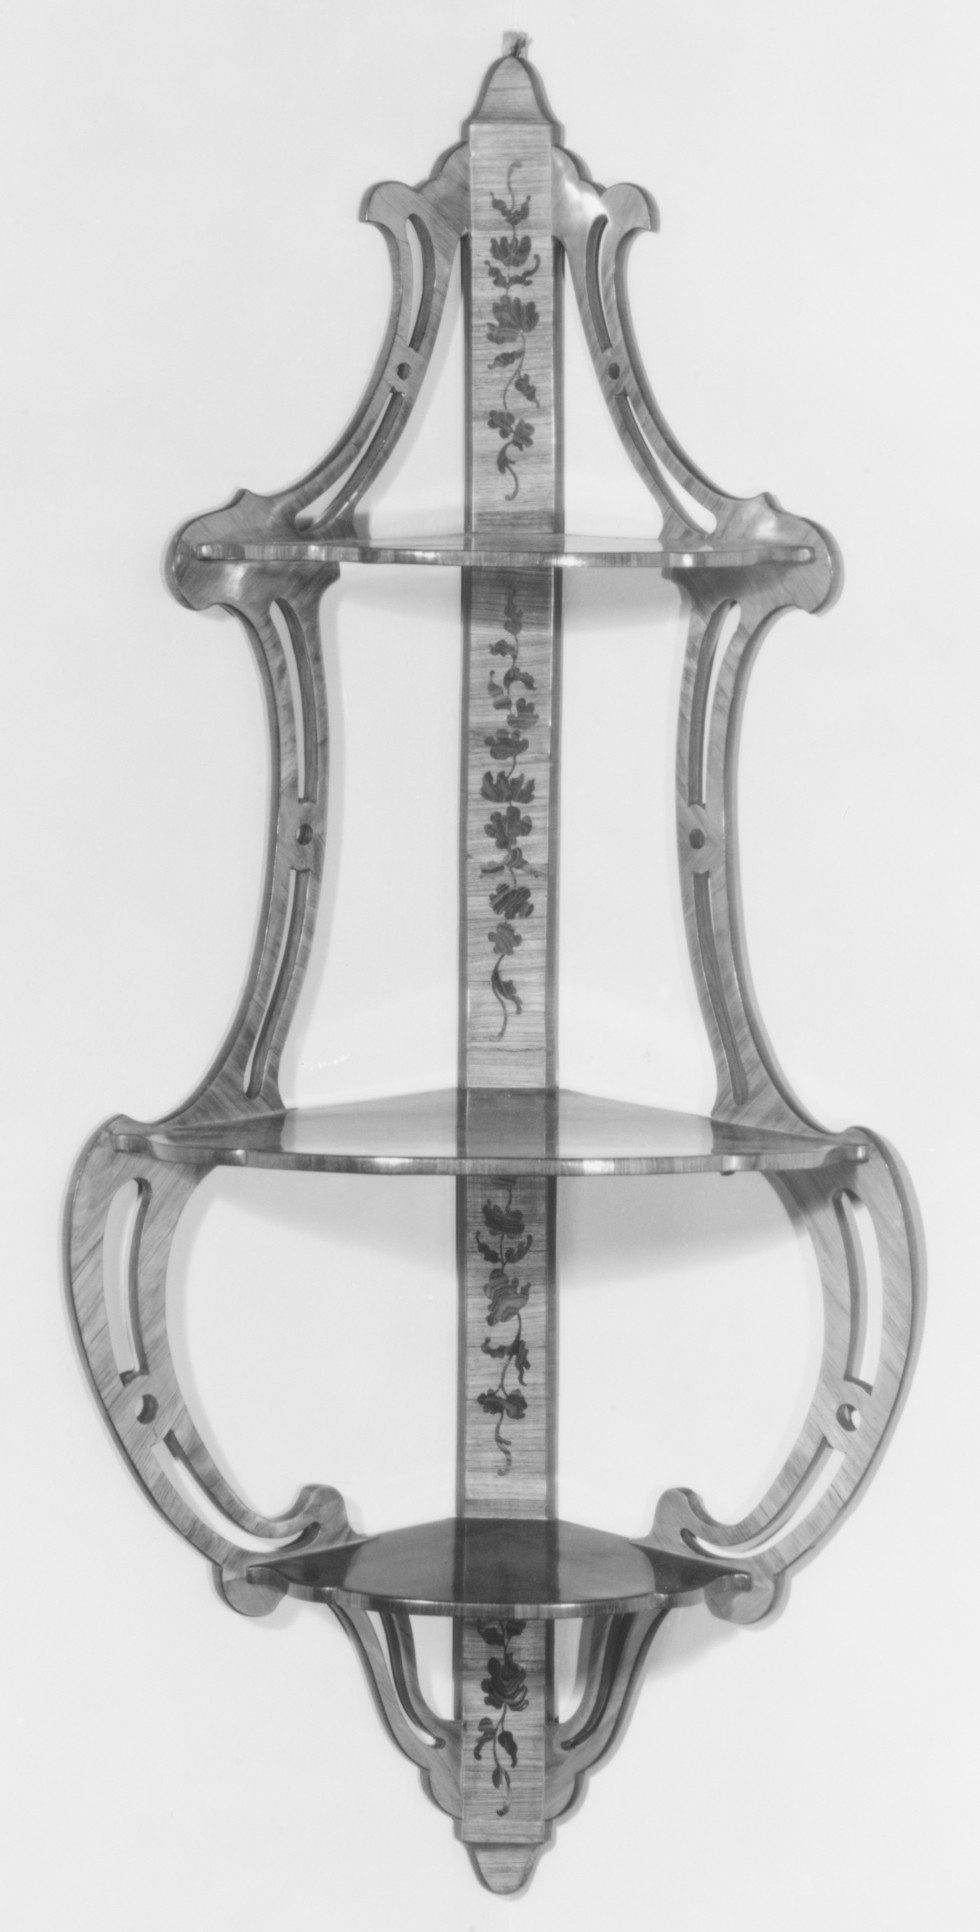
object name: corner shelf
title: Pair of corner shelves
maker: bernard ii van risenburgh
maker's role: maker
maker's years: 1696-1767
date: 1760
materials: wood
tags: flowers,furniture